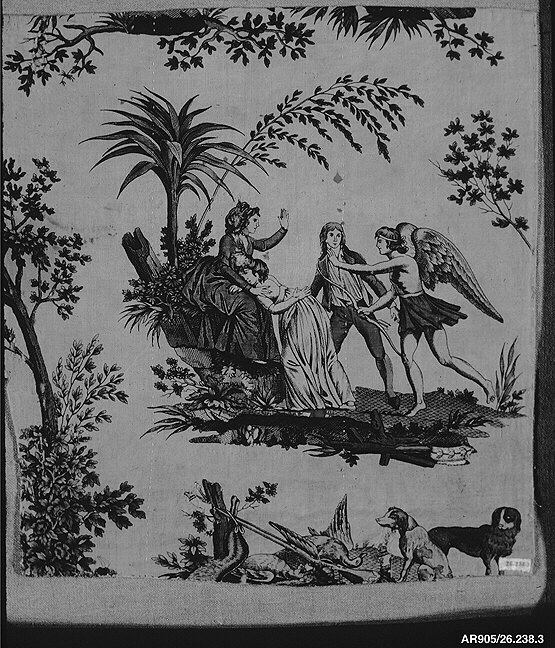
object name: piece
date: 1795-1799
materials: cotton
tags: birds,men,women,dogs,flowers,trees,angels